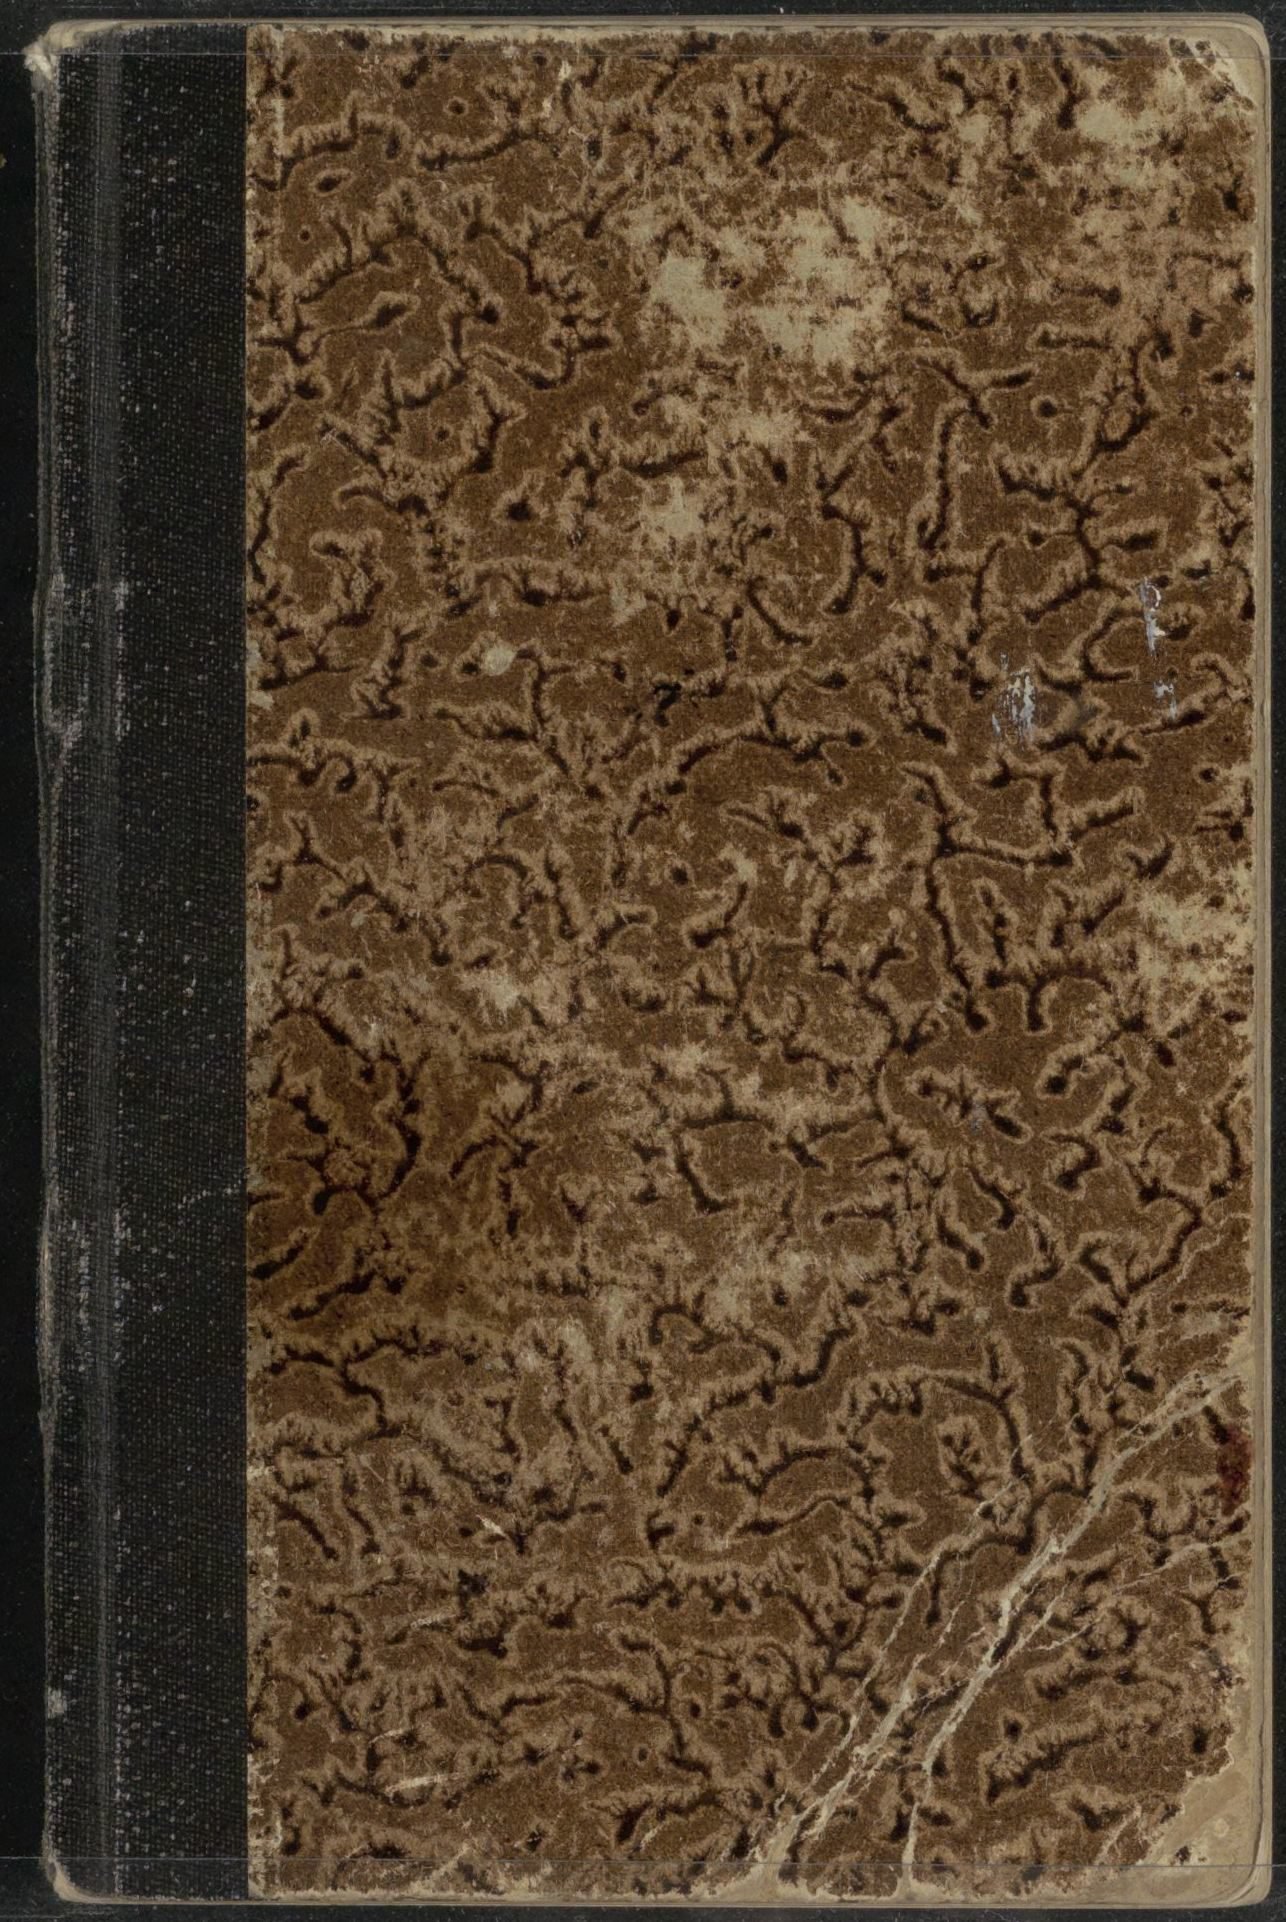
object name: sketchbook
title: Schetsboek met 46 bladen vervaardigd te Amsterdam, Haarlem en Antwerpen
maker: george hendrik breitner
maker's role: draughtsman, painter, print maker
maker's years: 1857-1923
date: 1886-1908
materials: chalk, paper, pencil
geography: haarlem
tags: urban housing, street, haarlem, antwerp, amsterdam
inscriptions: retailer's mark: ‘Gebrs. Simons/ Amsterdam./ Filiaal/ Heiligenweg 34/ Kantoorboek & Papierhandel./ Linieer- en Perforeer-inrichting./ No. 141 Blanco/ Bij nabestelling van dit boek, gelieve men/ bovenstaand nummer op te geven. / per doz f 1.60 per stuk 15’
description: Schetsboek bestaande uit 46 bladen met voornamelijk gezichten te Amsterdam en Haarlem.